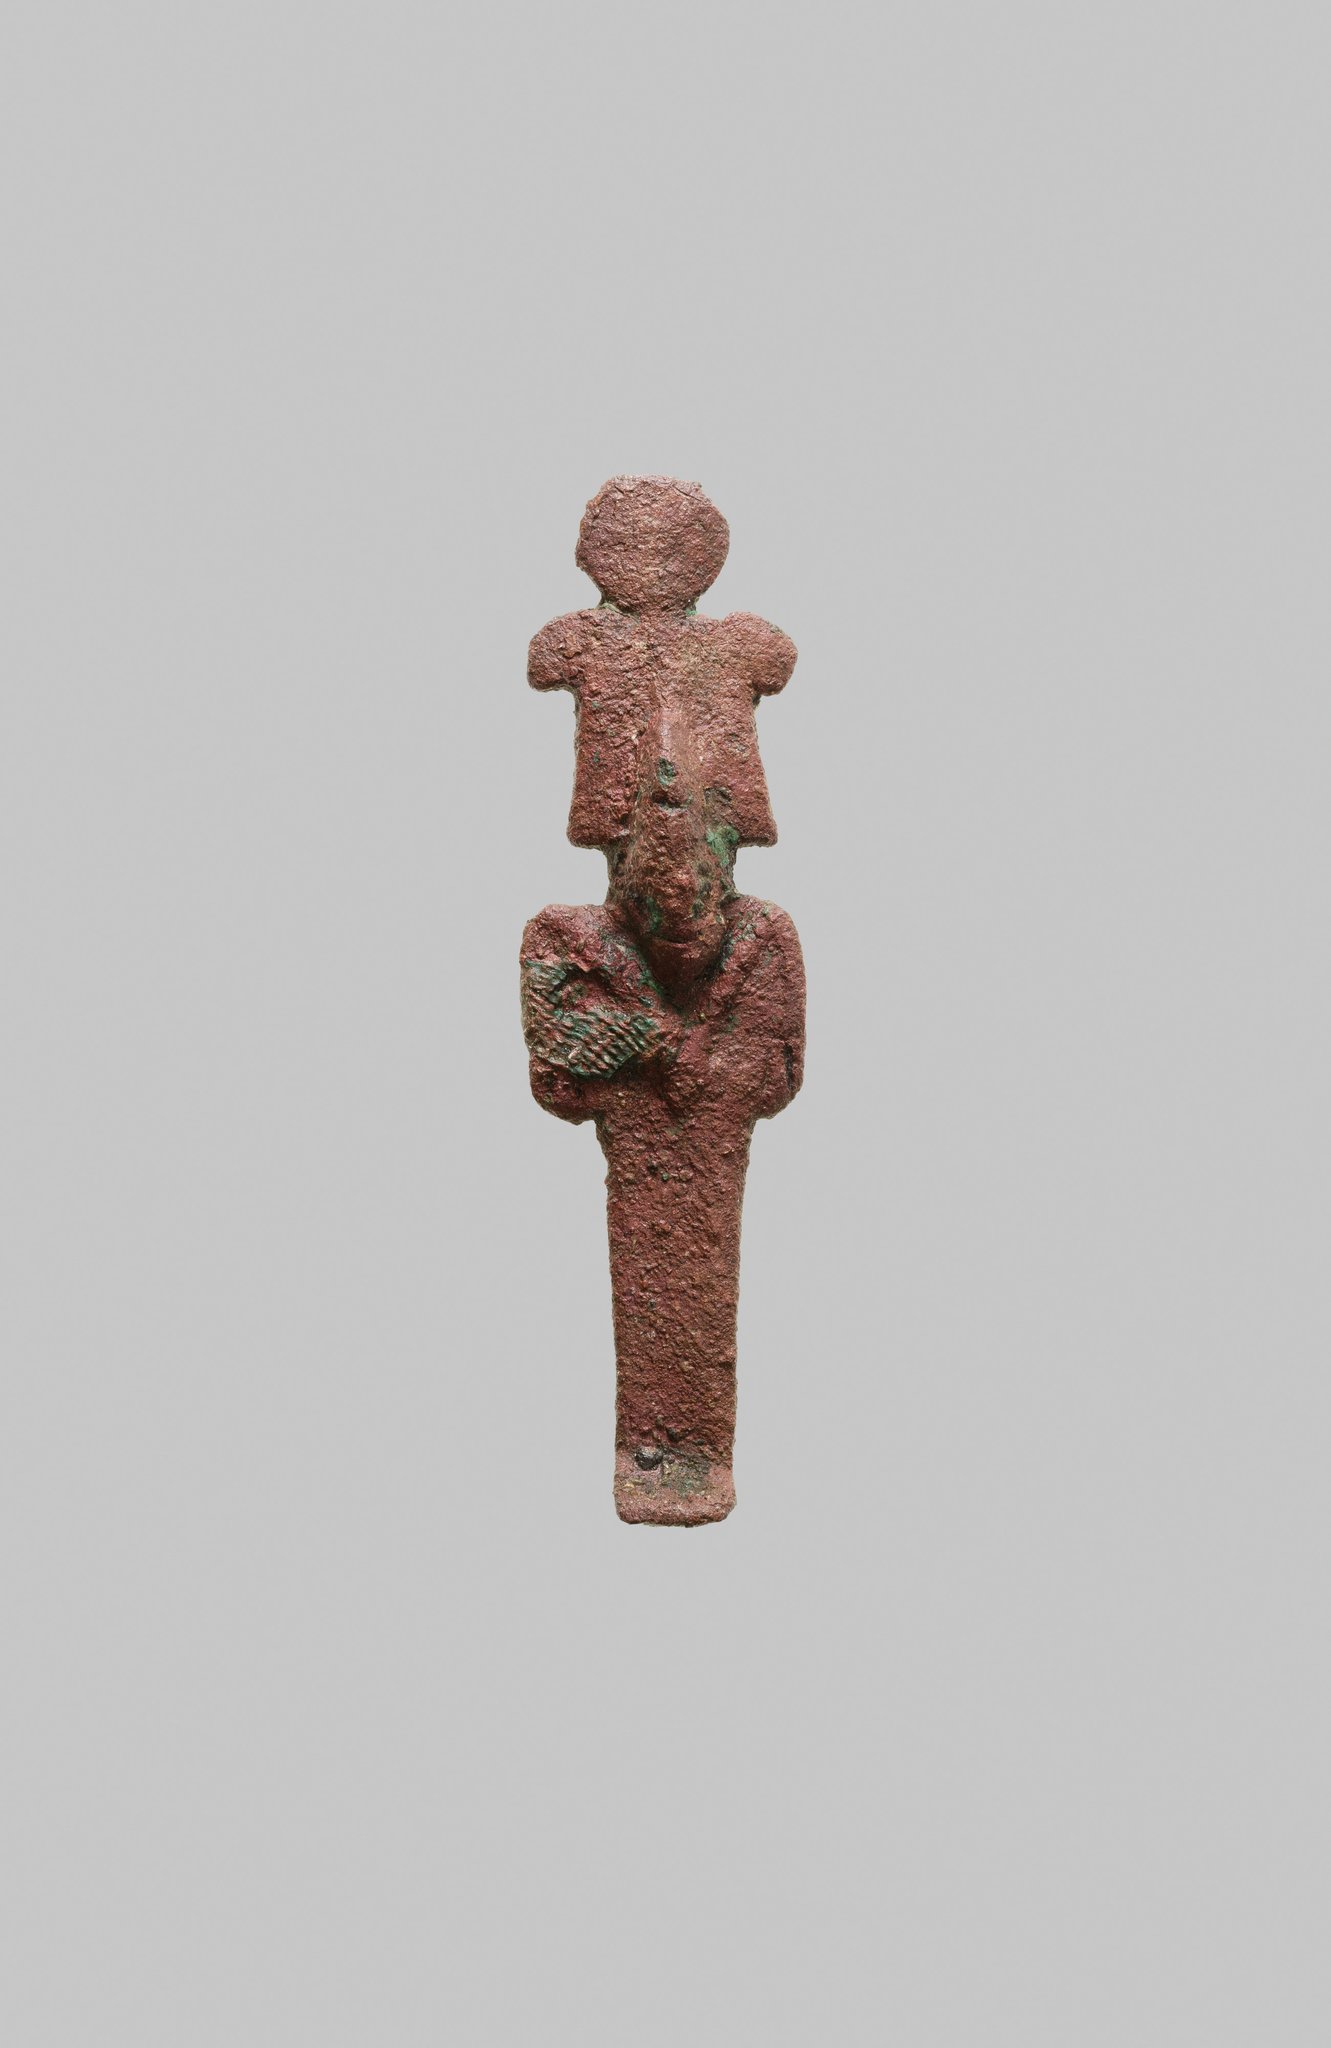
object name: statuette, osiris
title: Statuette of Osiris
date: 712-30 BCE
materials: bronze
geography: egypt